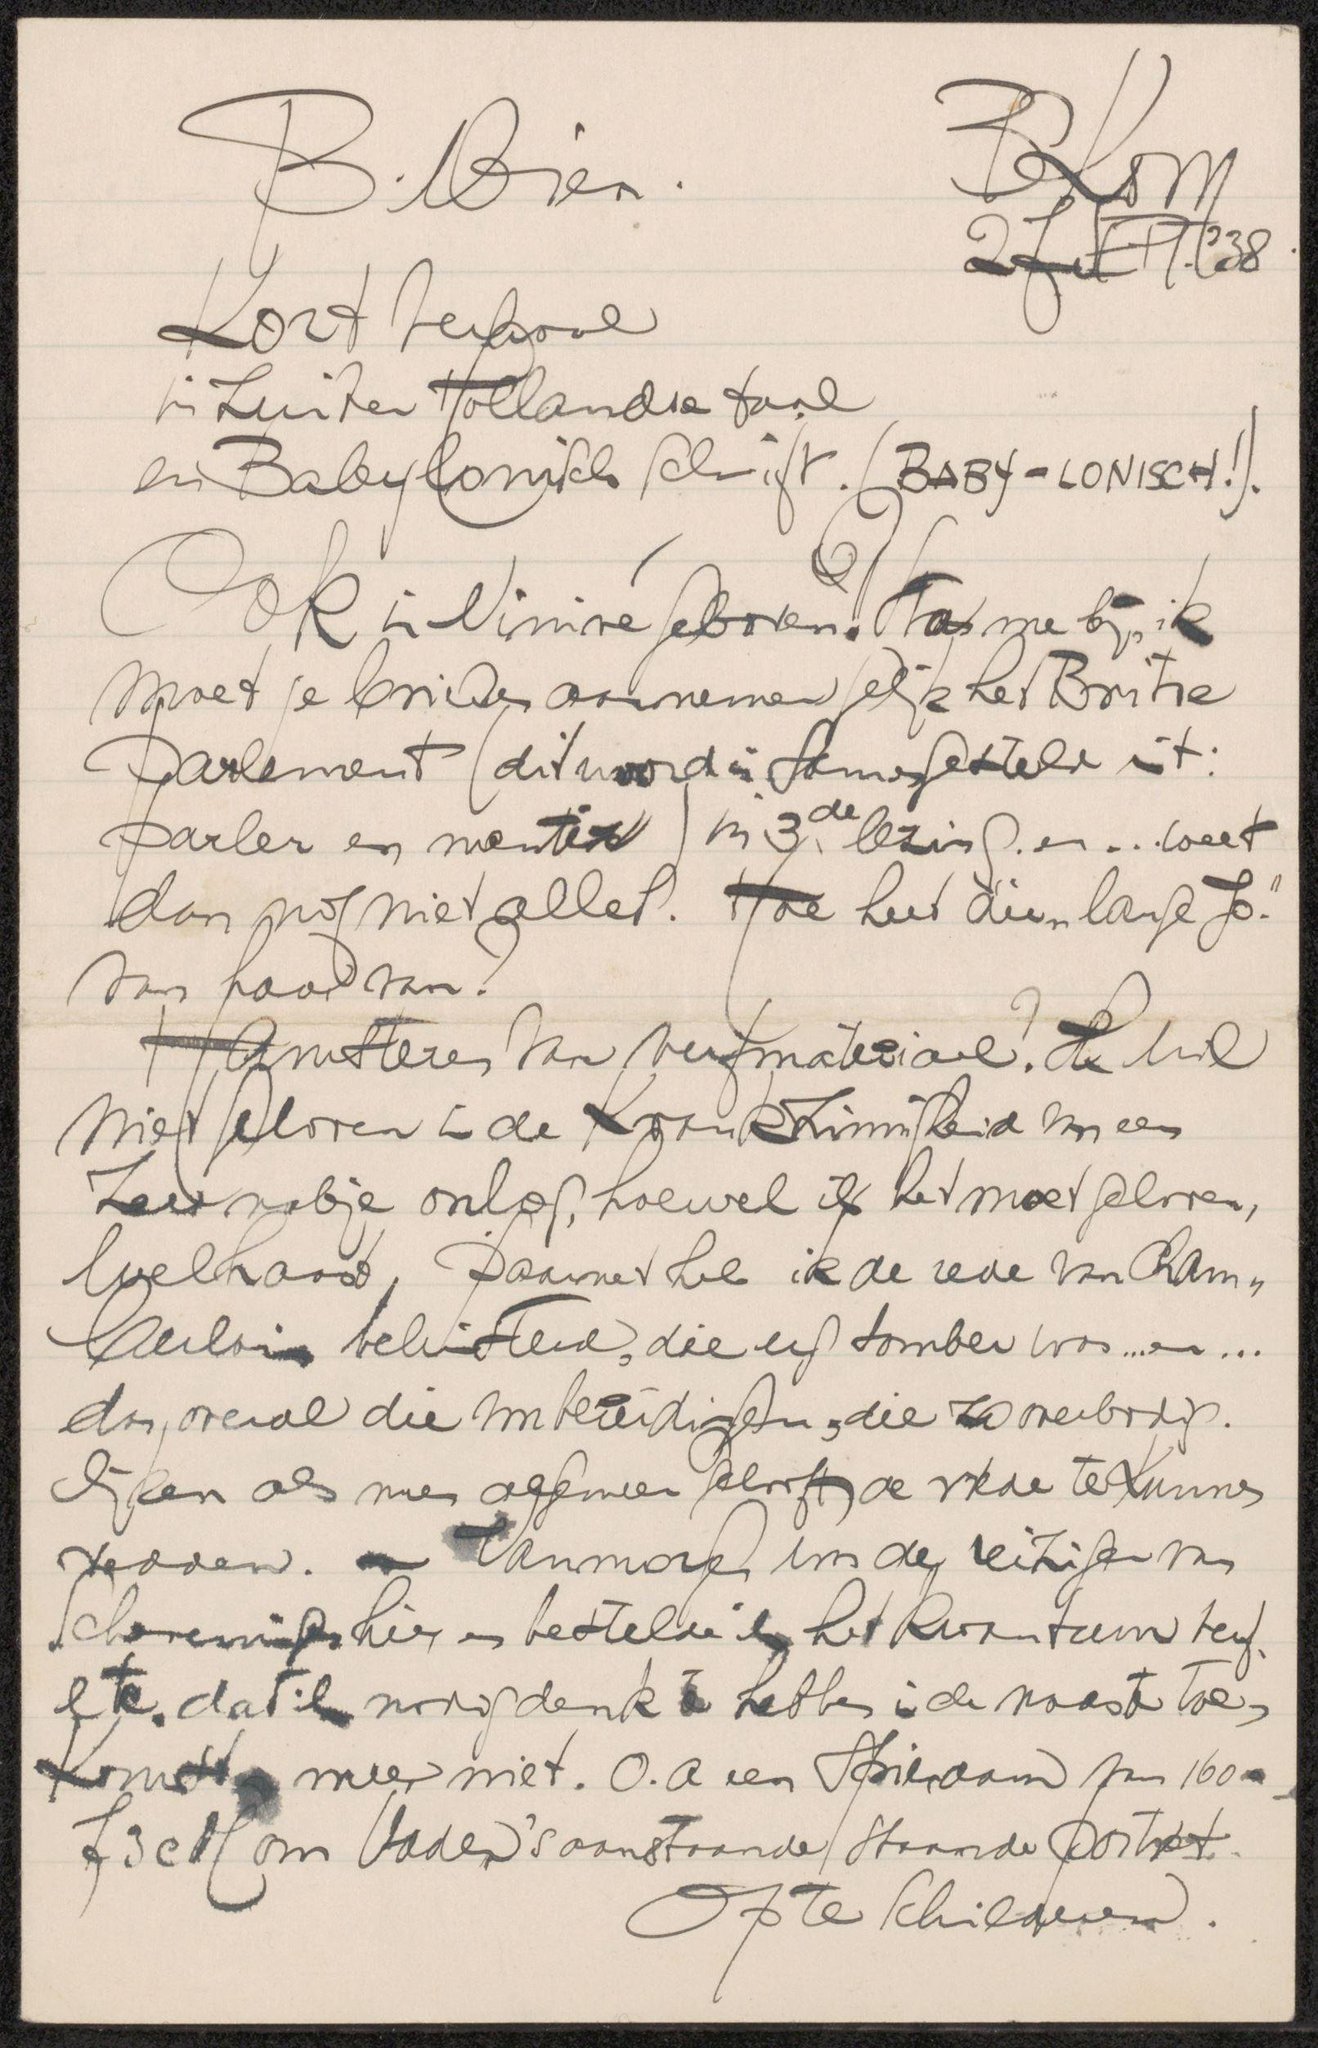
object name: letter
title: Brief aan Mien Cambier van Nooten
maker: dick ket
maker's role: draughtsman, print maker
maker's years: 1902-1940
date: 1938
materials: ink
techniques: pen, writing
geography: bennekom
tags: arnhem, mien cambier van nooten, haarlem, dollmaker, textile artist, nelly johanna hagelen-schilt, drawing, painting (including book-illumination, miniature-painting), amsterdam